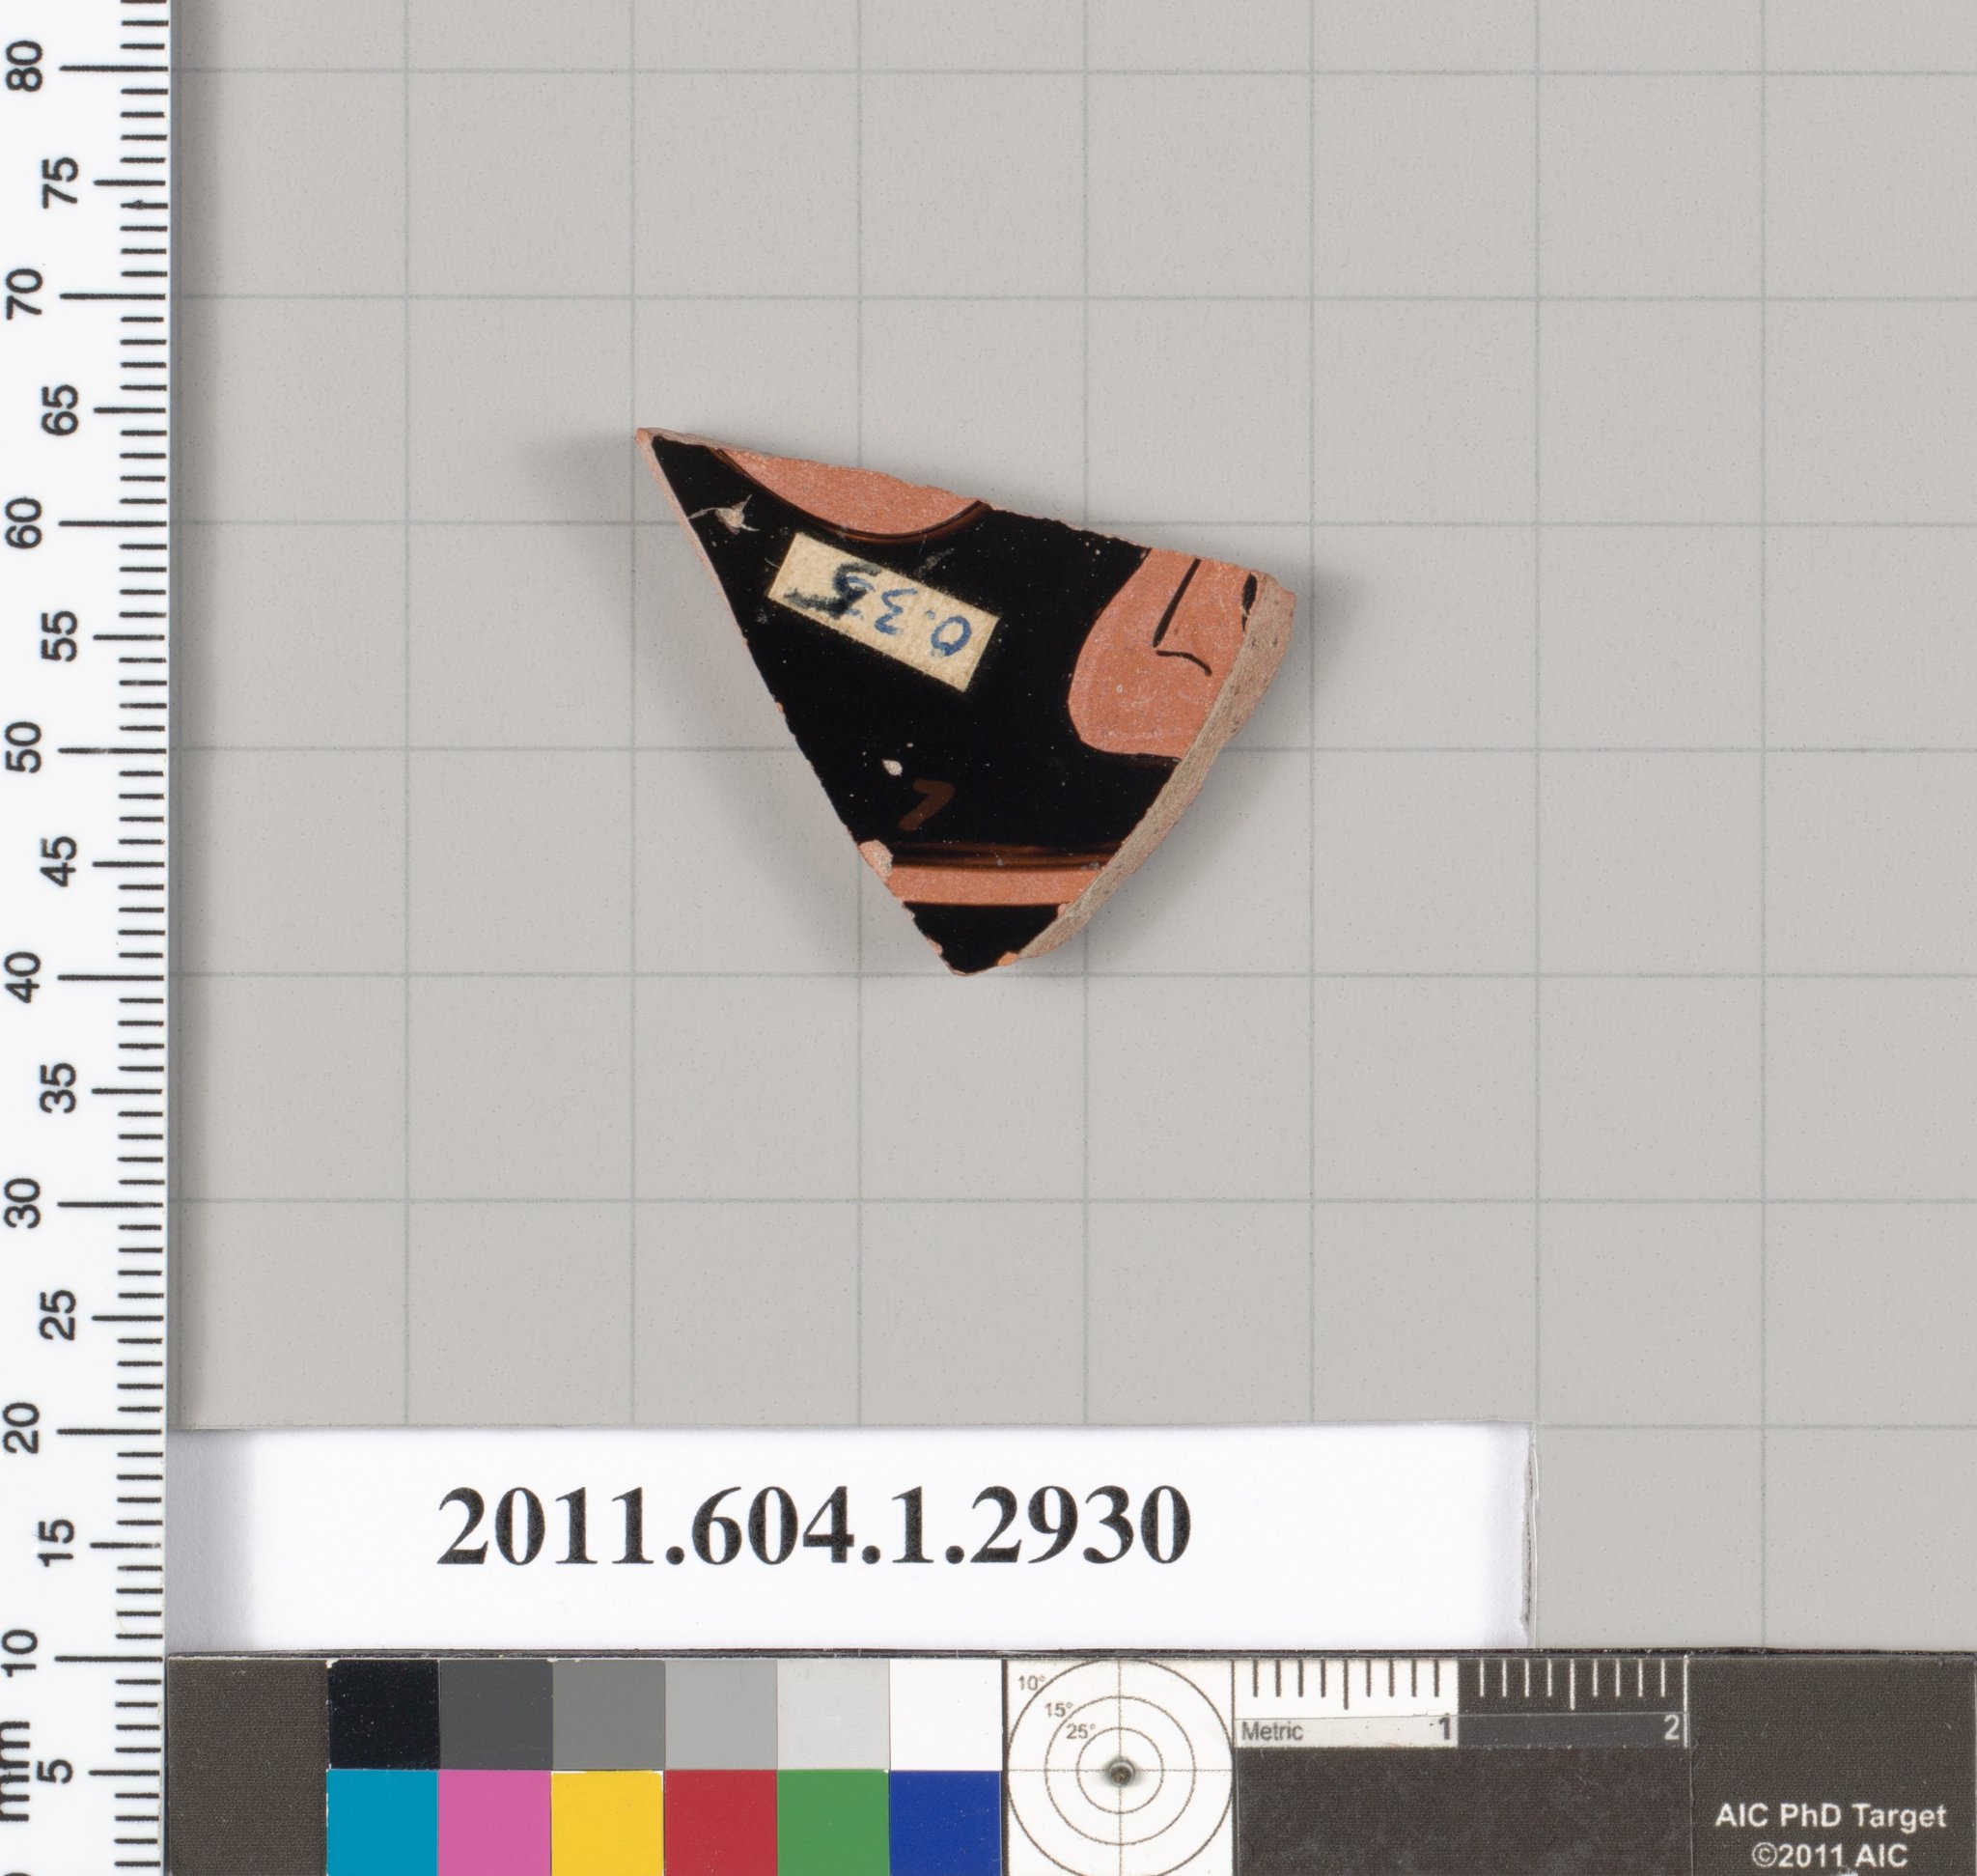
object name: kylix fragment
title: Terracotta fragment of a kylix (drinking cup)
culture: greek, attic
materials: terracotta